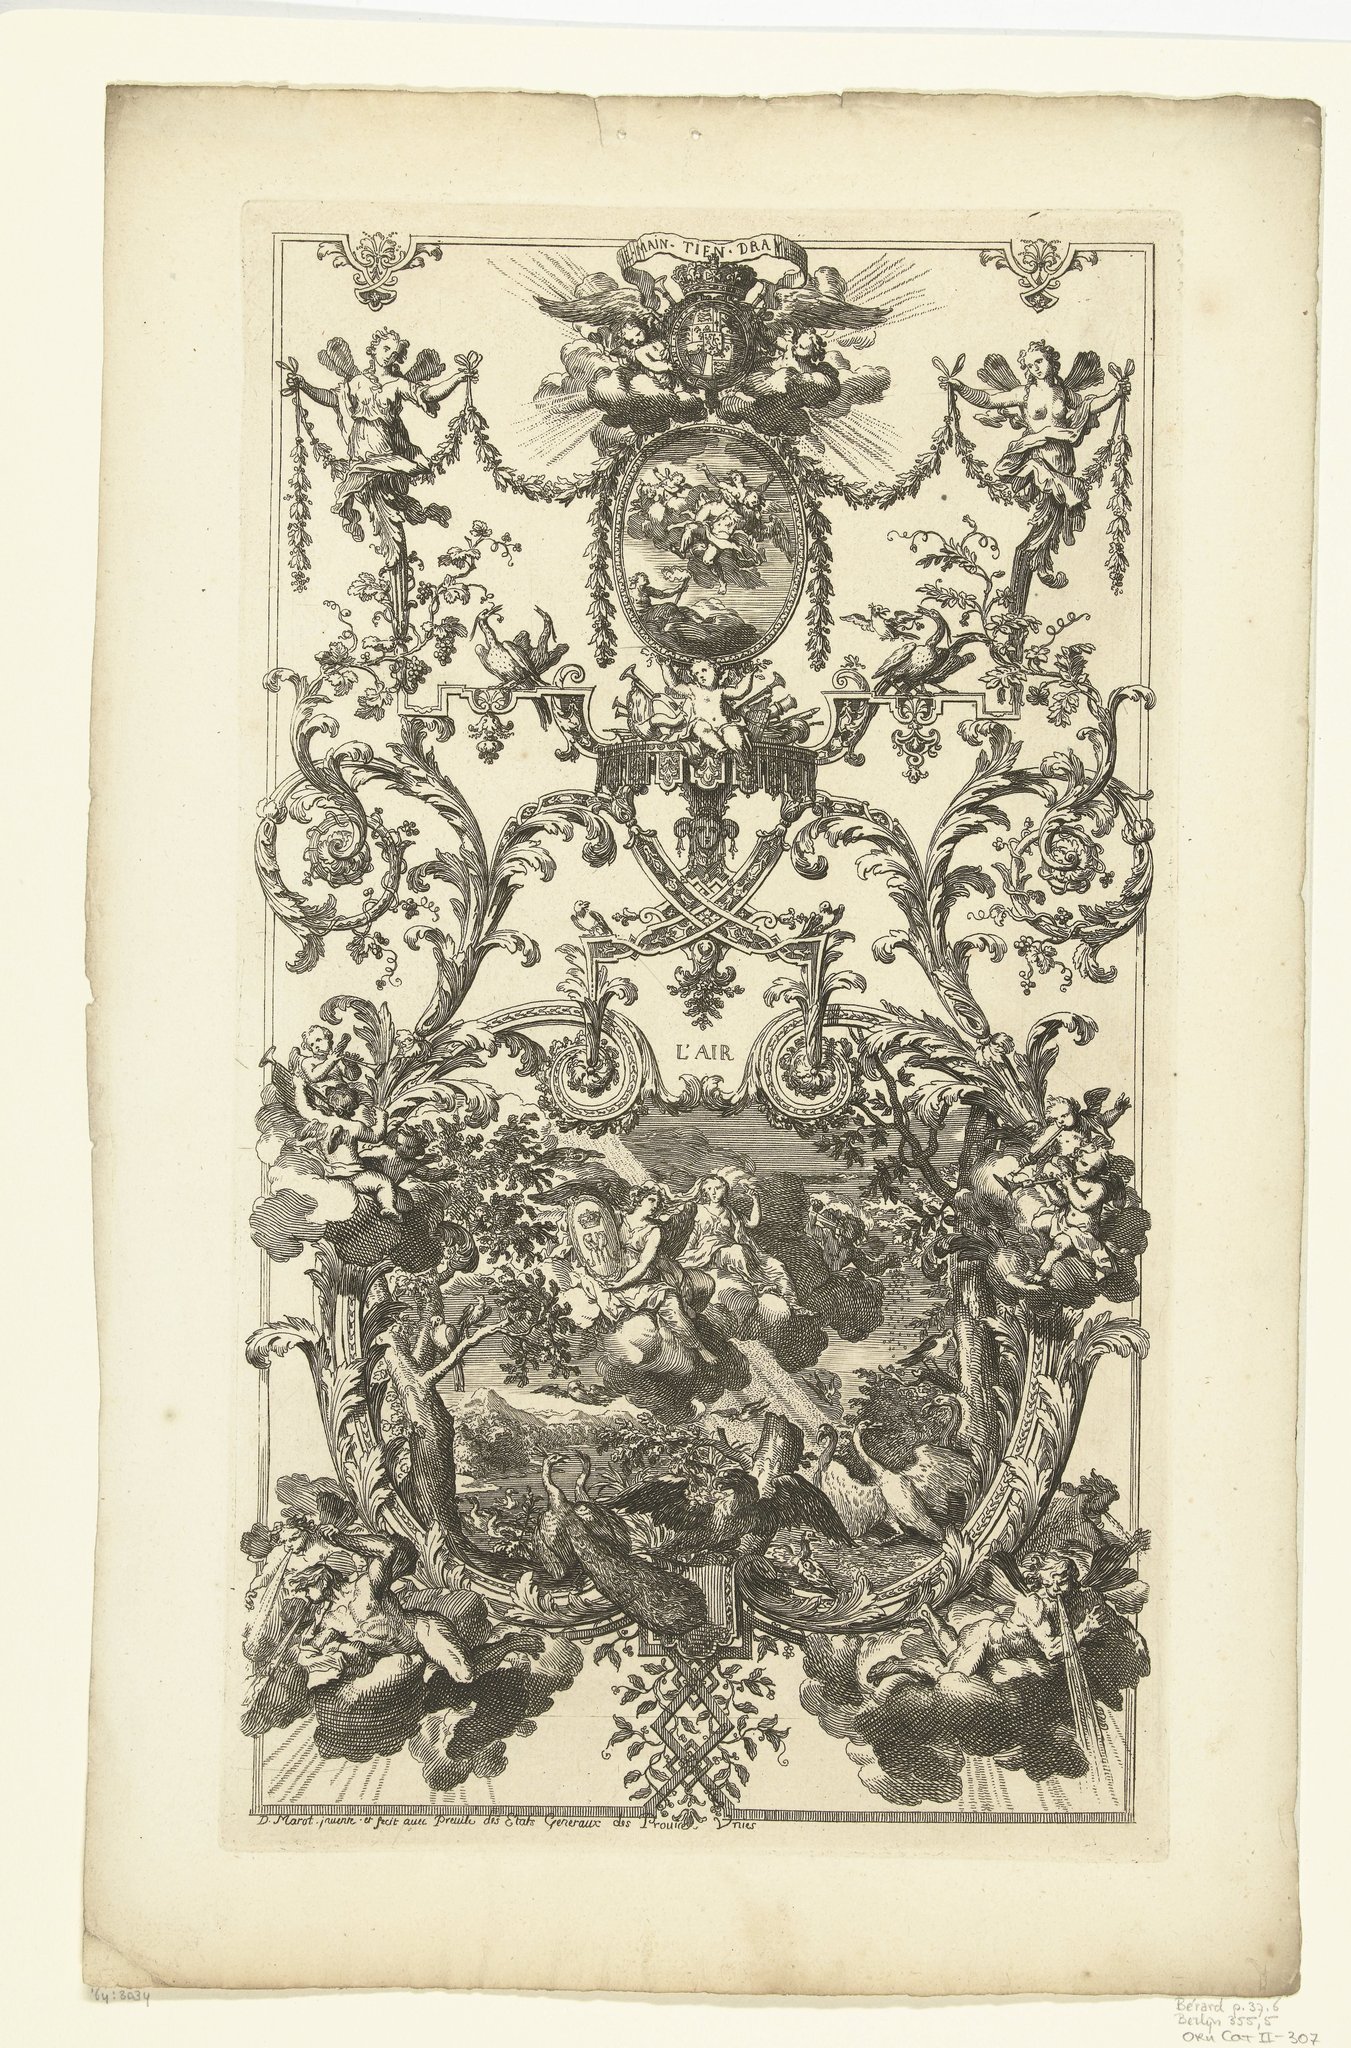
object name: ornament print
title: L'air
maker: daniël marot (i)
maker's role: draughtsman, print maker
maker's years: 1661-1752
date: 1712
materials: paper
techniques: etching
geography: netherlands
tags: air (one of the four elements), vase ~ ornament, angels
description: Bovenaan staat het wapen van Engeland afgebeeld, onderaan een cartouche met een engel die een gemonogrammeerd wapenschild vasthoudt en dieren. Middenonder een banderol met de tekst IE. MAIN.TIEN.DRAY. Uit serie van 6 bladen, waarvan 4 bladen met de vier elementen en twee bladen waarop telkens twee verticale panelen staan.